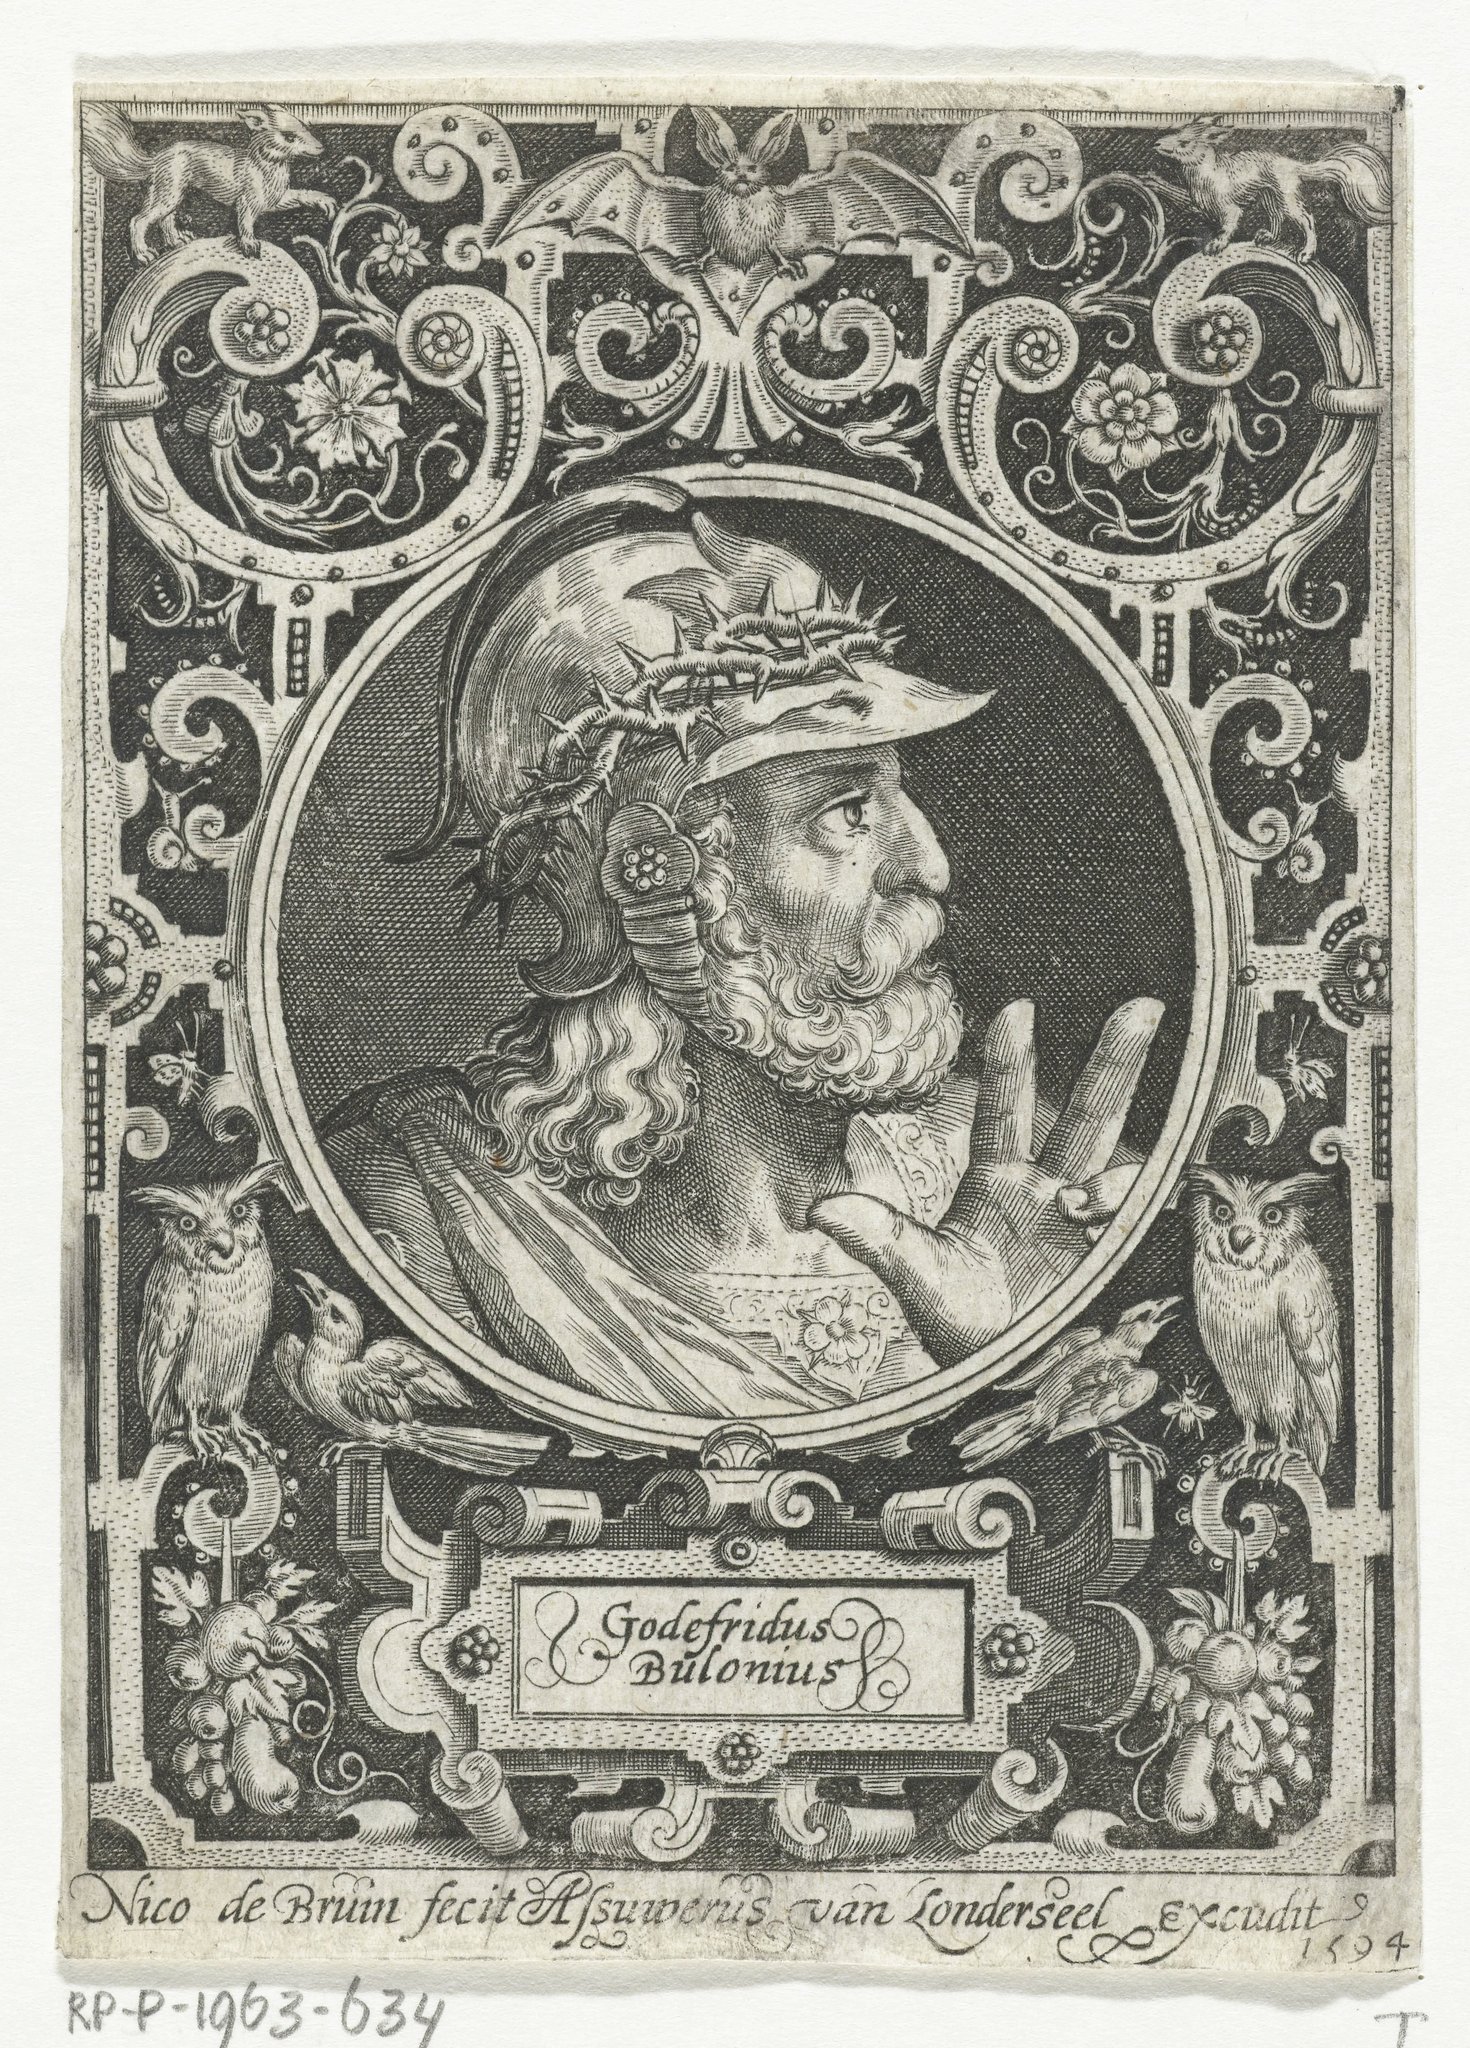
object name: print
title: Portret van Godfried van Bouillon in medaillon binnen rechthoekige omlijsting met ornamenten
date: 1594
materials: paper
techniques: engraving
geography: netherlands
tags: godfrey of bouillon, godefroy of bouillon (one of the nine worthies)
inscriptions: collector's mark: Lugt 2228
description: Portret van Godfried van Bouillon met helm en doornenkroon in medaillon binnen rechthoekige omlijsting met krulornamenten en vogels en een vleermuis.